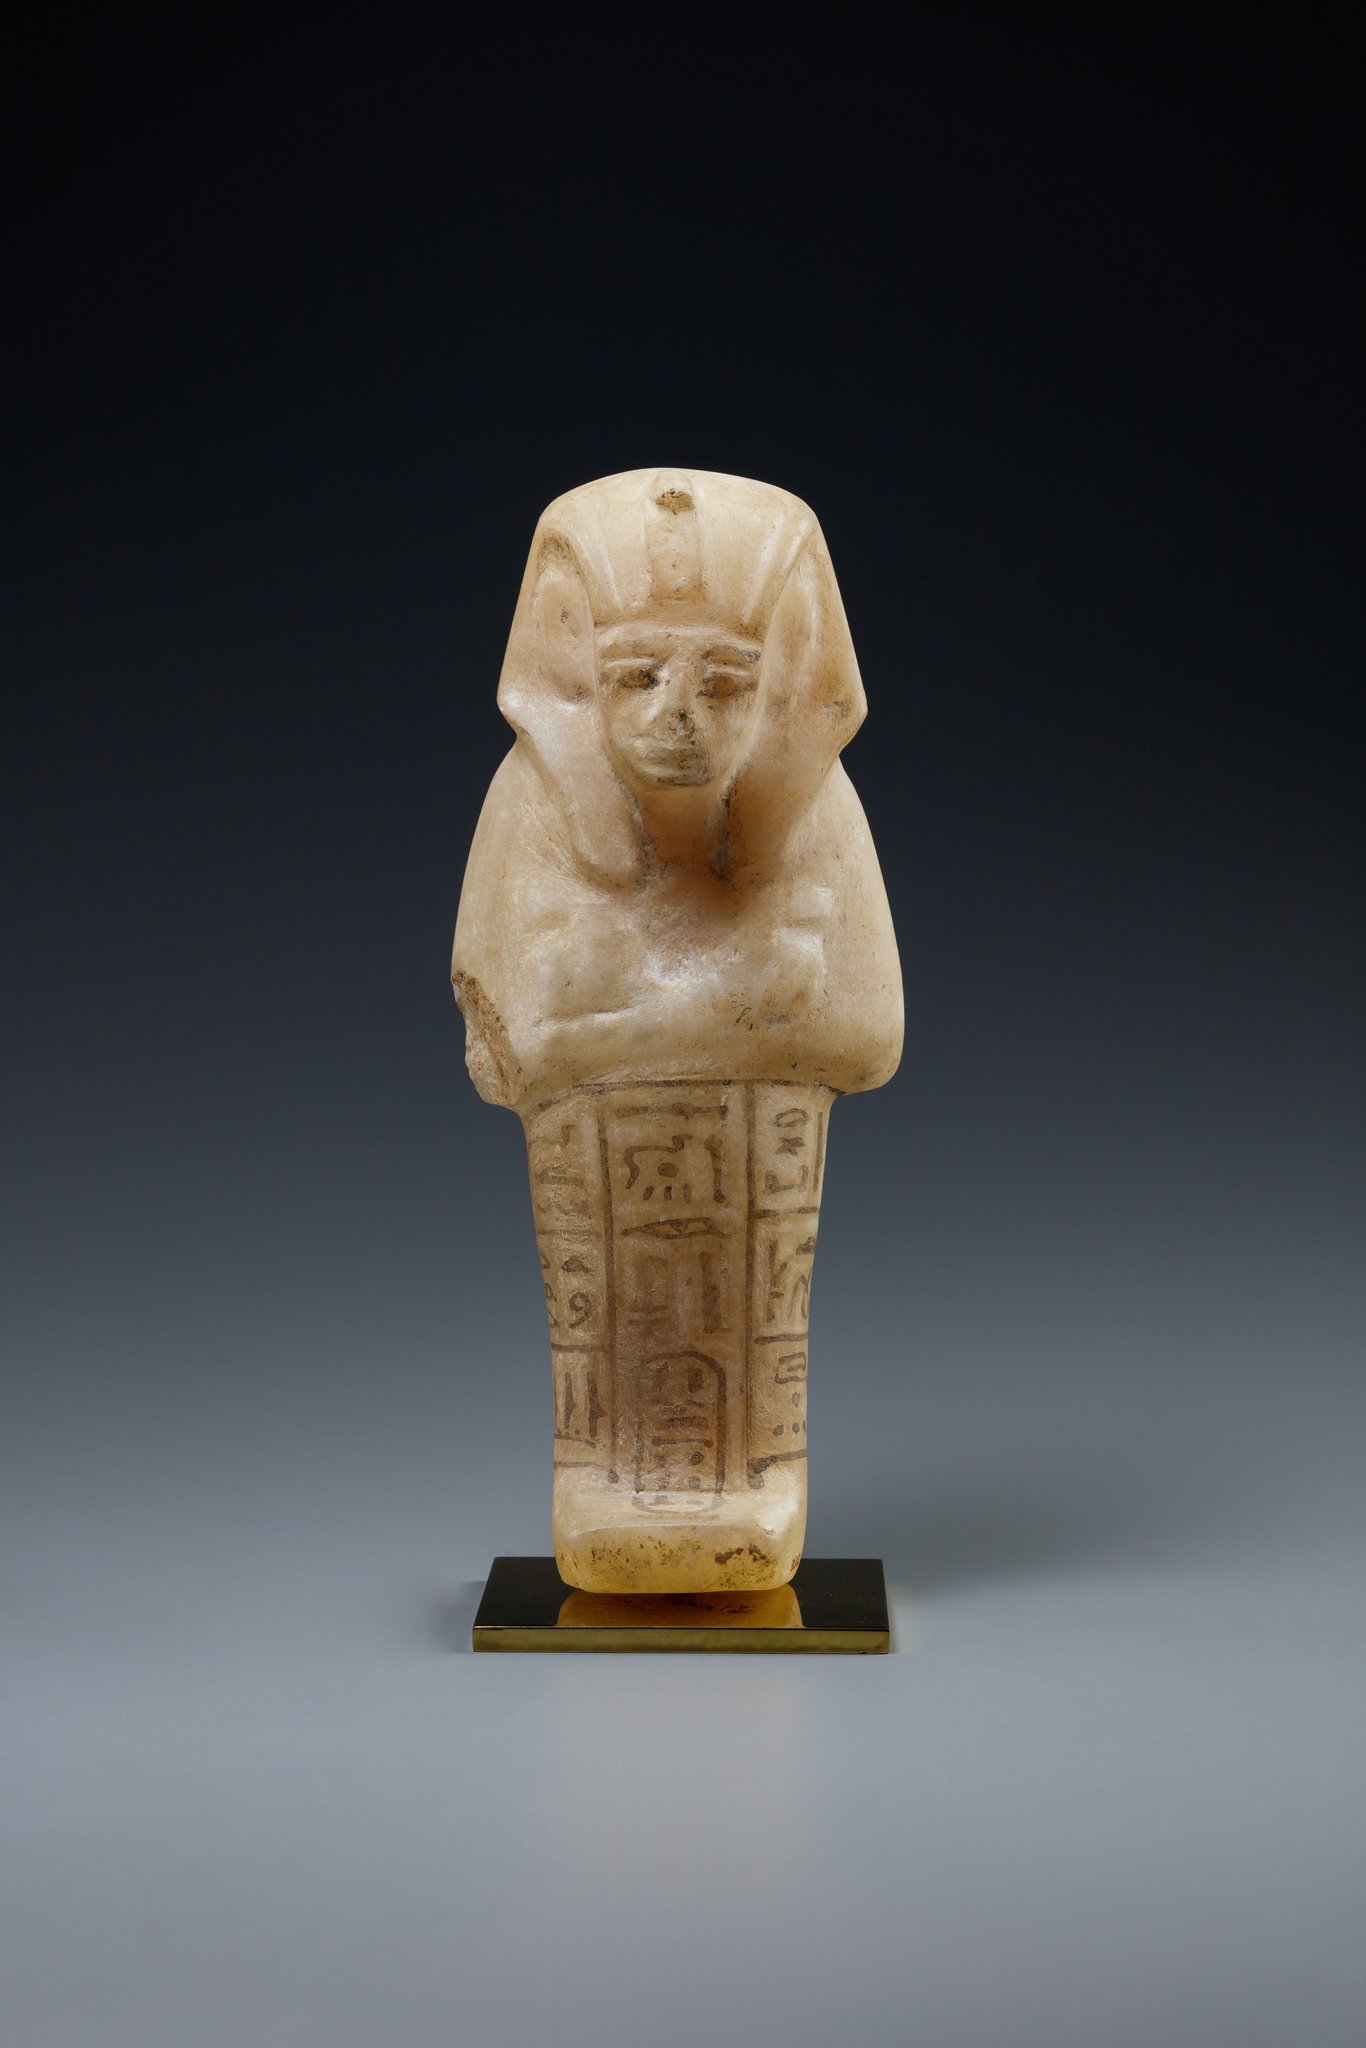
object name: shabti, siptah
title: Shabti of Siptah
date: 1237-1200 BCE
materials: stone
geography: egypt